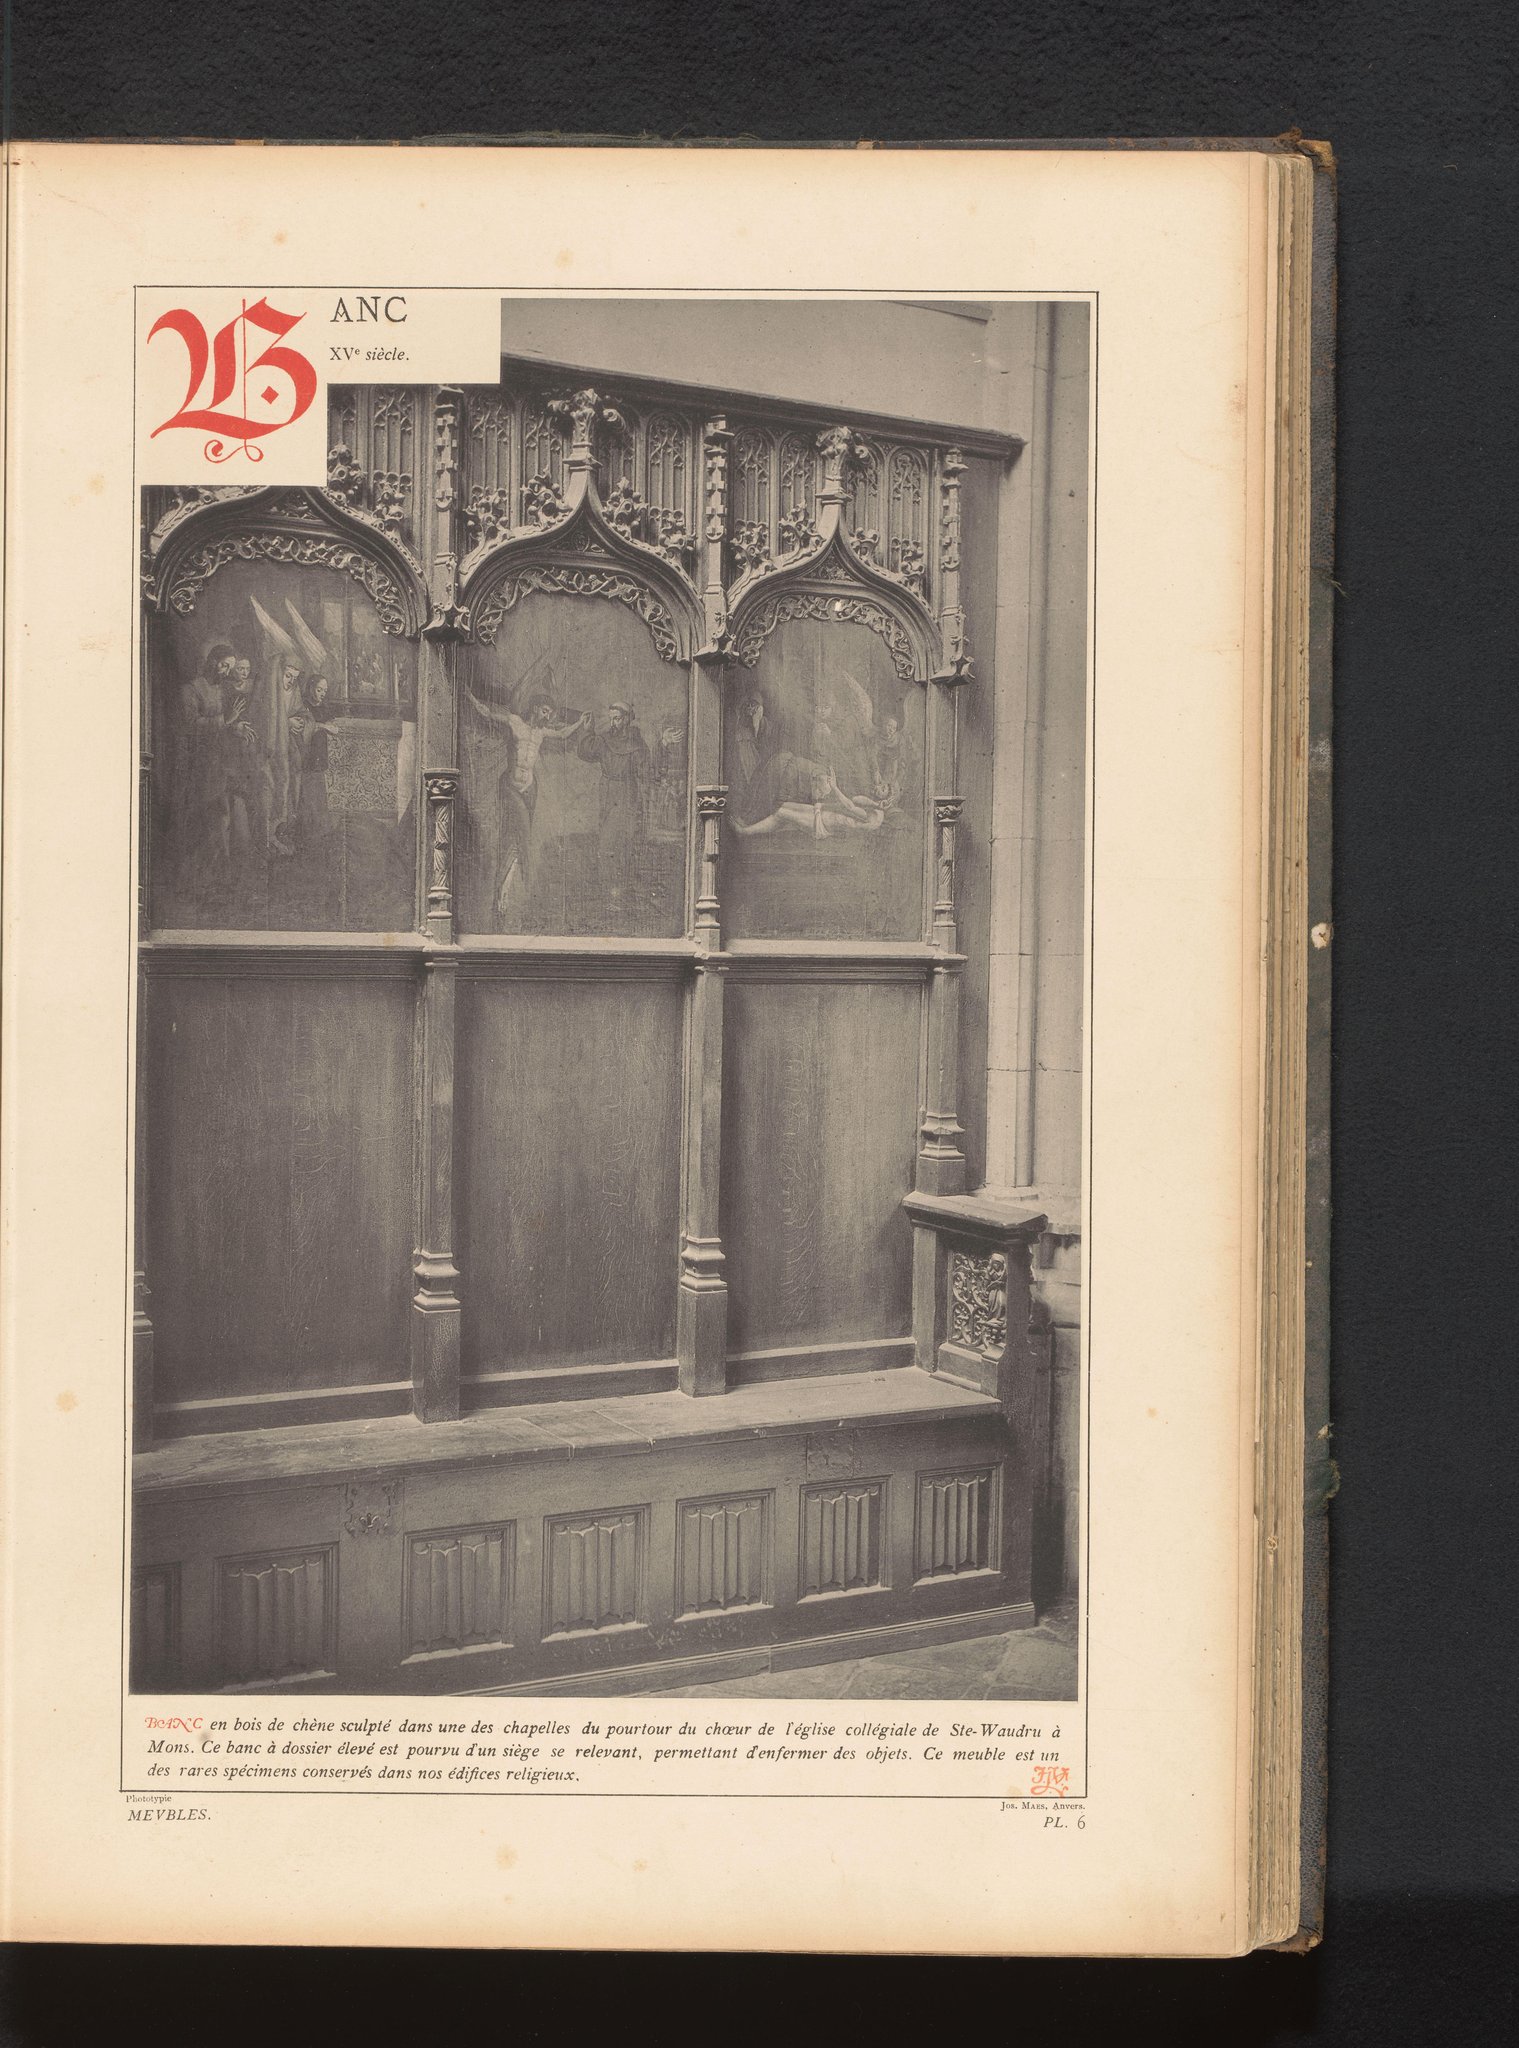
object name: photomechanical print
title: Koorbank in de Sint-Waltrudiskerk in Mons, België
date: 1882-1887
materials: paper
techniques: photograph, photolithography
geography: sint-waltrudiskerk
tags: bench, parts of church interior: choir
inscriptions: monogram: ‘JJvY’, inscription: ‘MEUBLES. - PL. 6.’, inscription: ‘BANC en bois (...)’